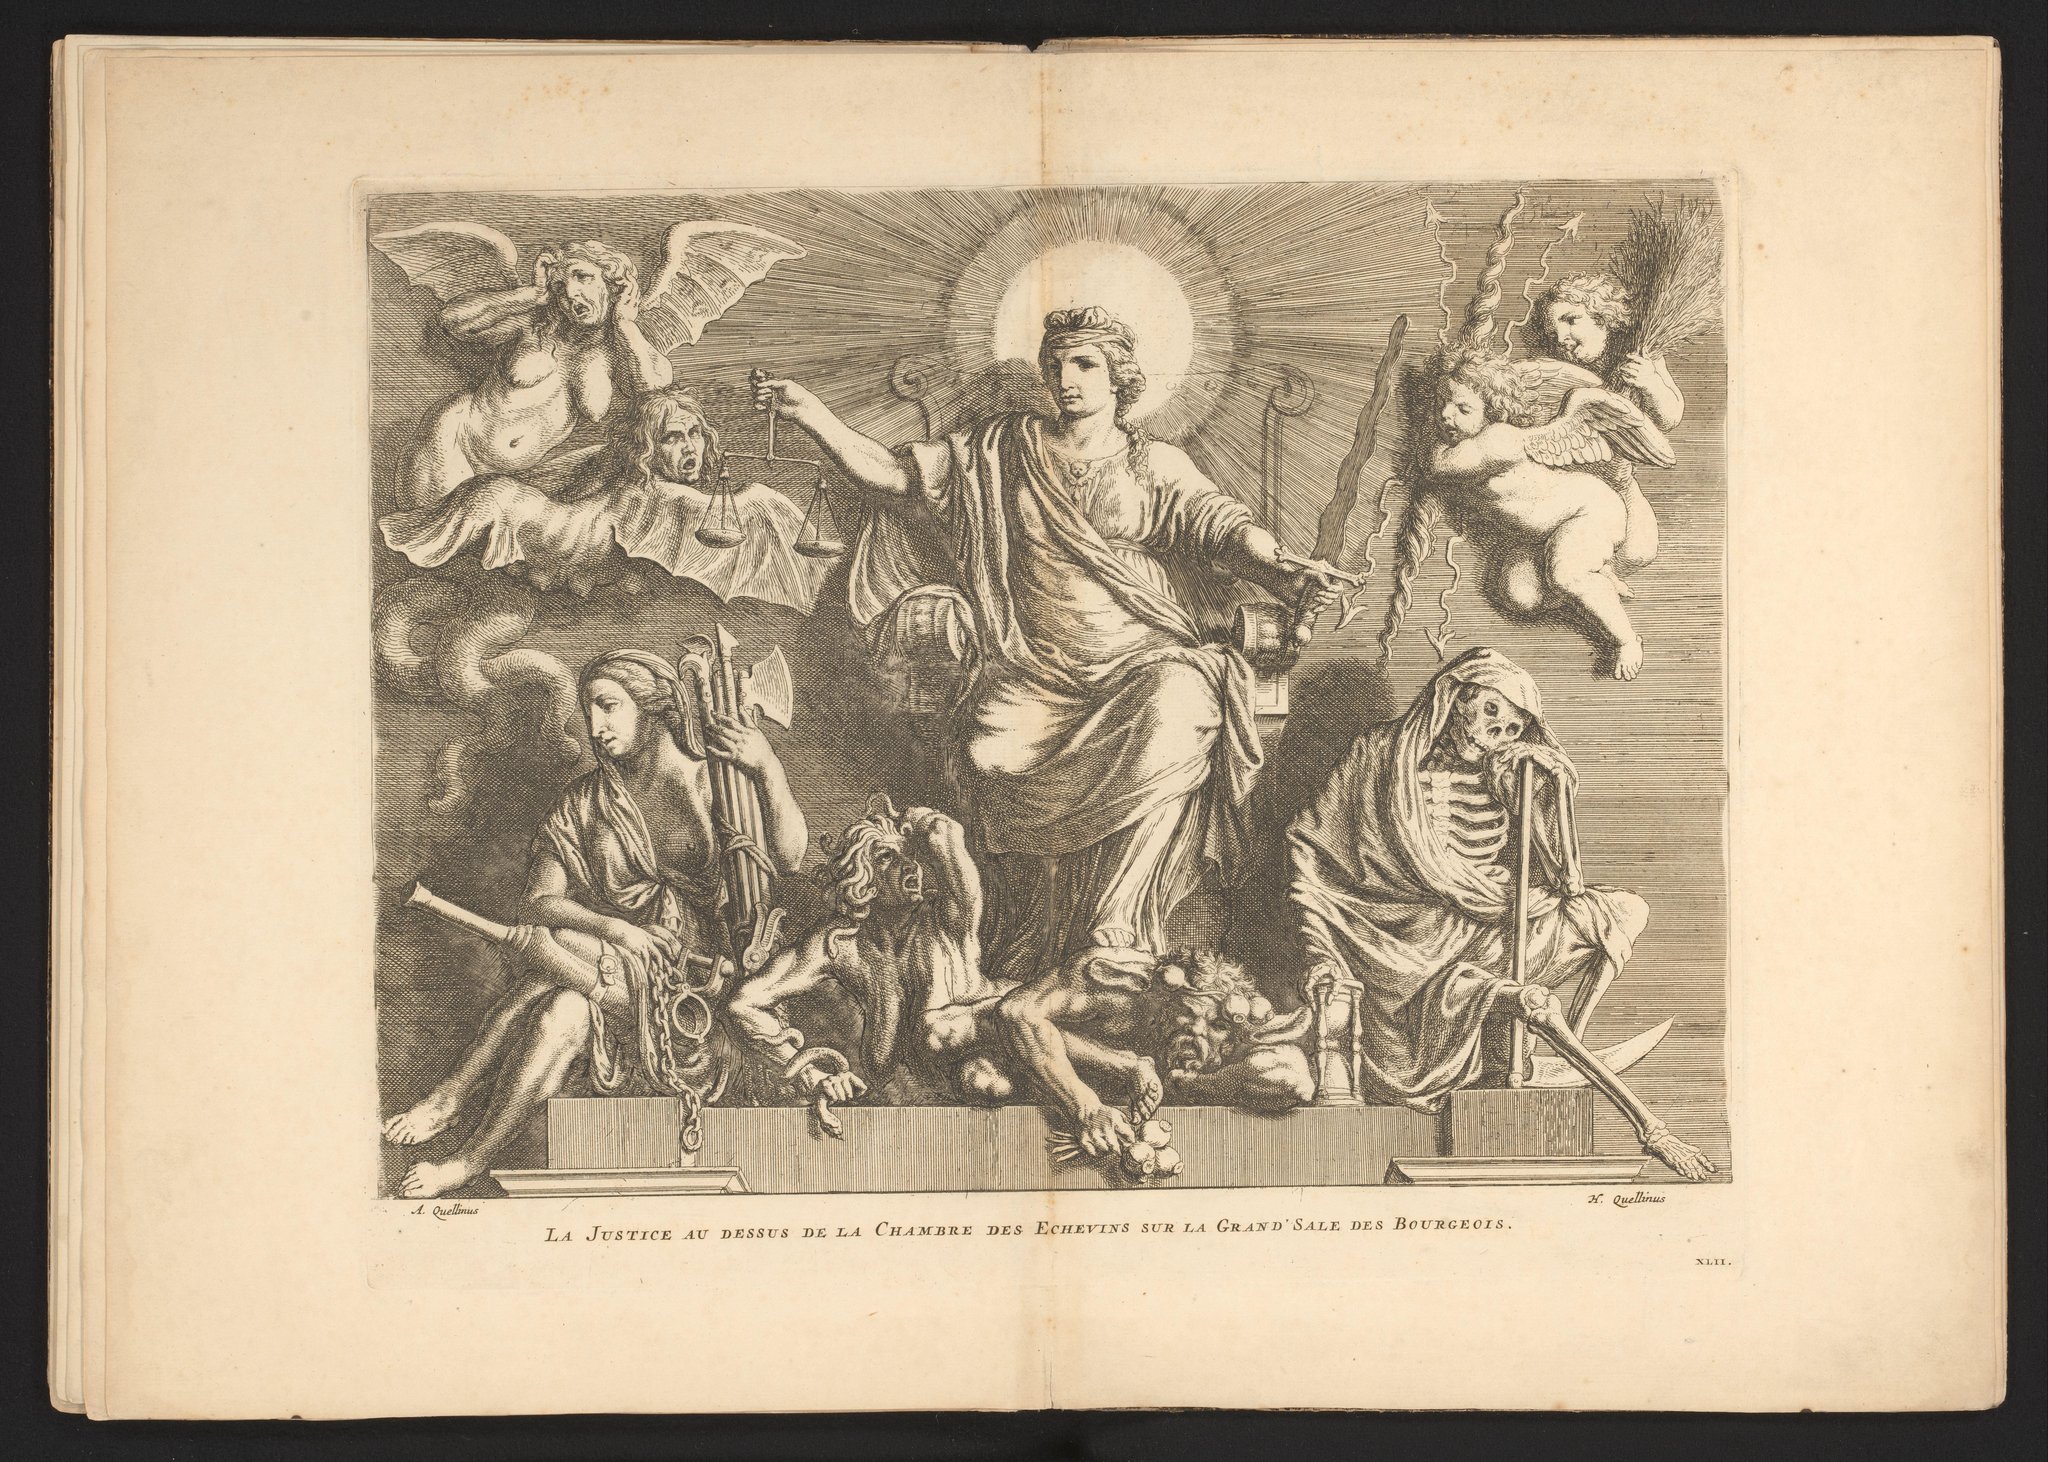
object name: book illustration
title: Beeldengroep met allegorie op de Gerechtigheid aan de westzijde van de Burgerzaal in het Stadhuis op de Dam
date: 1719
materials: paper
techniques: engraving, etching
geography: amsterdam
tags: death as skeleton (+ death with scythe), justitia (justice) as roman personification, sculpture, punishment; 'castigo', 'pena', 'punitione' (ripa), invidia (envy) as roman personification, (story of) midas, harpies (classical mythology)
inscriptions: collector's mark: ‘Kunstnijverheidschool Quellinus Amsterdam Frans Halsstraat 14’, collector's mark: ‘Instituut voor kunst-nijverheidsonderwijs Gabriël Metsustraat No. 16 Amsterdam’, inscription: ‘no. 2 platen/ Omslag fragmenten der Beeldoengroepen van het paleis/ te Amsterdam’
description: Prent waarschijnlijk uit: Architecture peinture et sculpture de la Maison de Ville d'Amsterdam, representee en CIX. figures en taille-douce (…). Amsterdam: David Mortier, 1719. Deze staat werd ook gebruikt in de uitgave van dit werk door Gerard Valck uit 1719, en in: Bouw schilder en beeldhouwkonst, van het Stadhuis te Amsteldam, vertoont in CIX figuuren (…). Amsterdam: Covens & Mortier & Covens Jr., s.a. (1774-1783). Een eerdere staat werd gebruikt in: Secunca pars Praecipuarum effigierum ac ornamentorum amplissime Curiae Amstelrodamensis (…). Amsterdam: Artus Quellinus (I), 1663. En in de editie uit 1668, uitgegeven door Frederik de Wit.